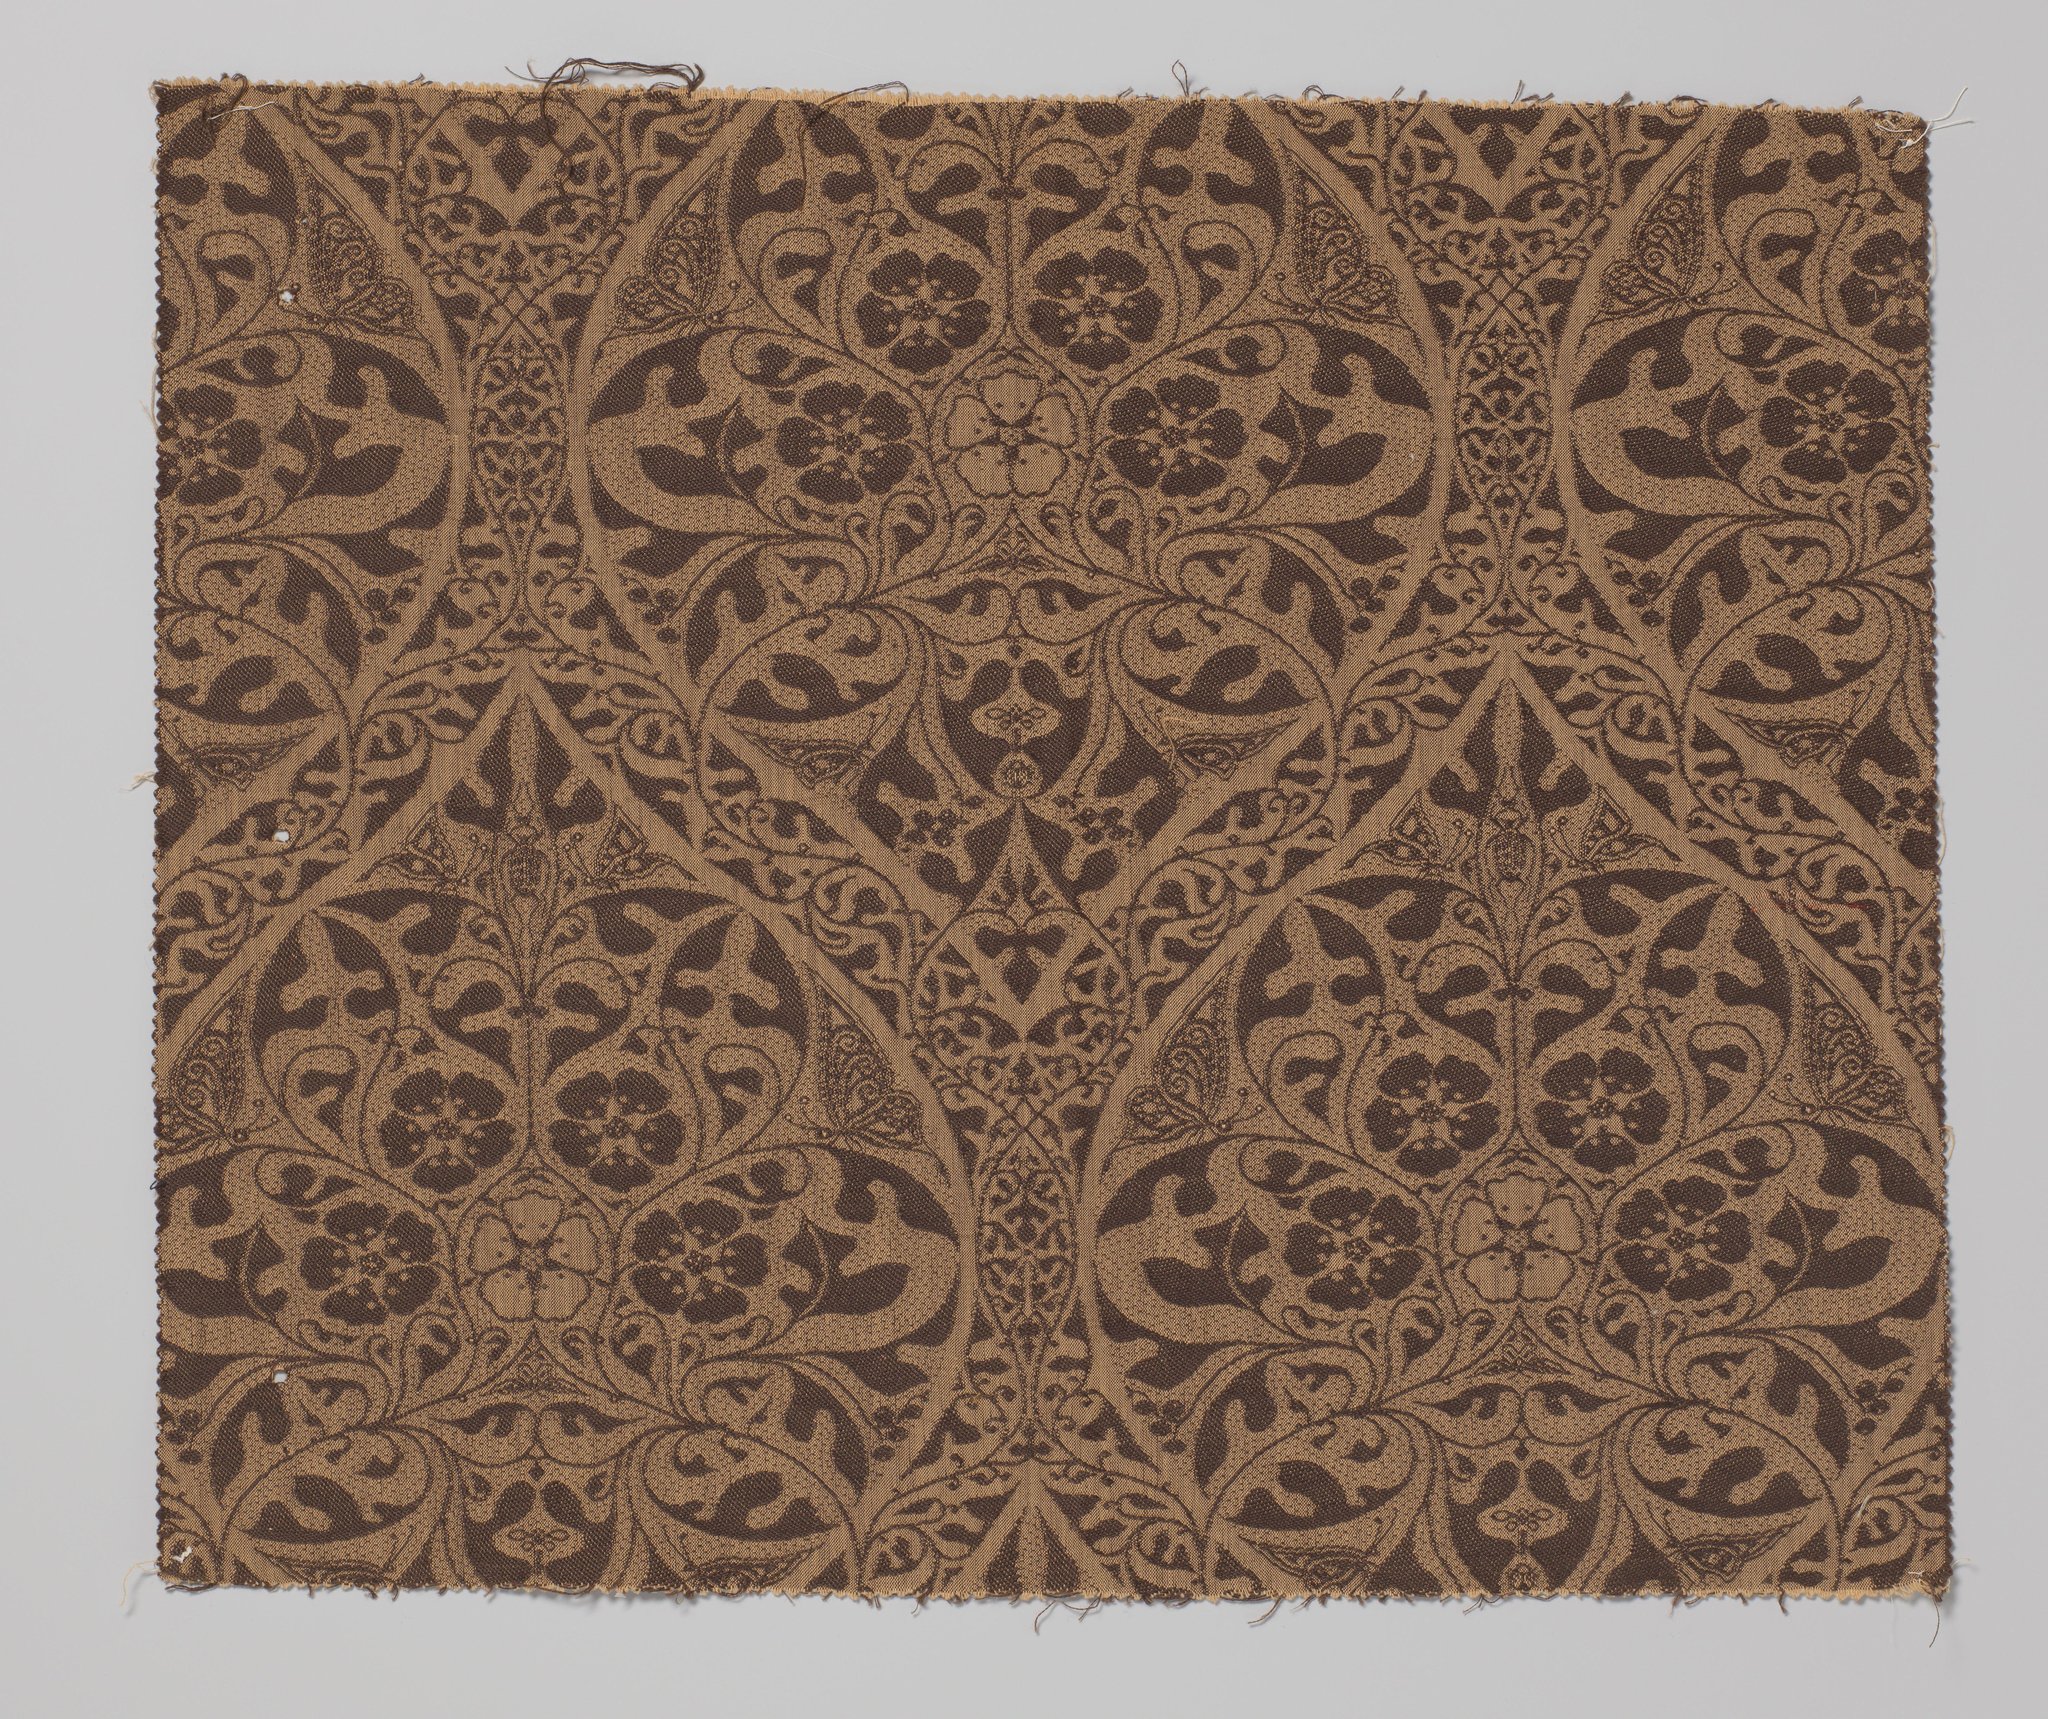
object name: fragment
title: Fragment bespanningsstof met patroon van bloemen, bladeren en vlinders binnen spitsovale banden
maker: theo nieuwenhuis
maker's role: designer, draughtsman, print maker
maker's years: 1866-1951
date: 1900-1925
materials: cotton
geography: netherlands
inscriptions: number: ‘322’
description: Fragment bespanningsstof met patroon van bloemen, bladeren en vlinders binnen spitsovale banden. Donkerbruine inslag op licht mokkakleurige inslag.